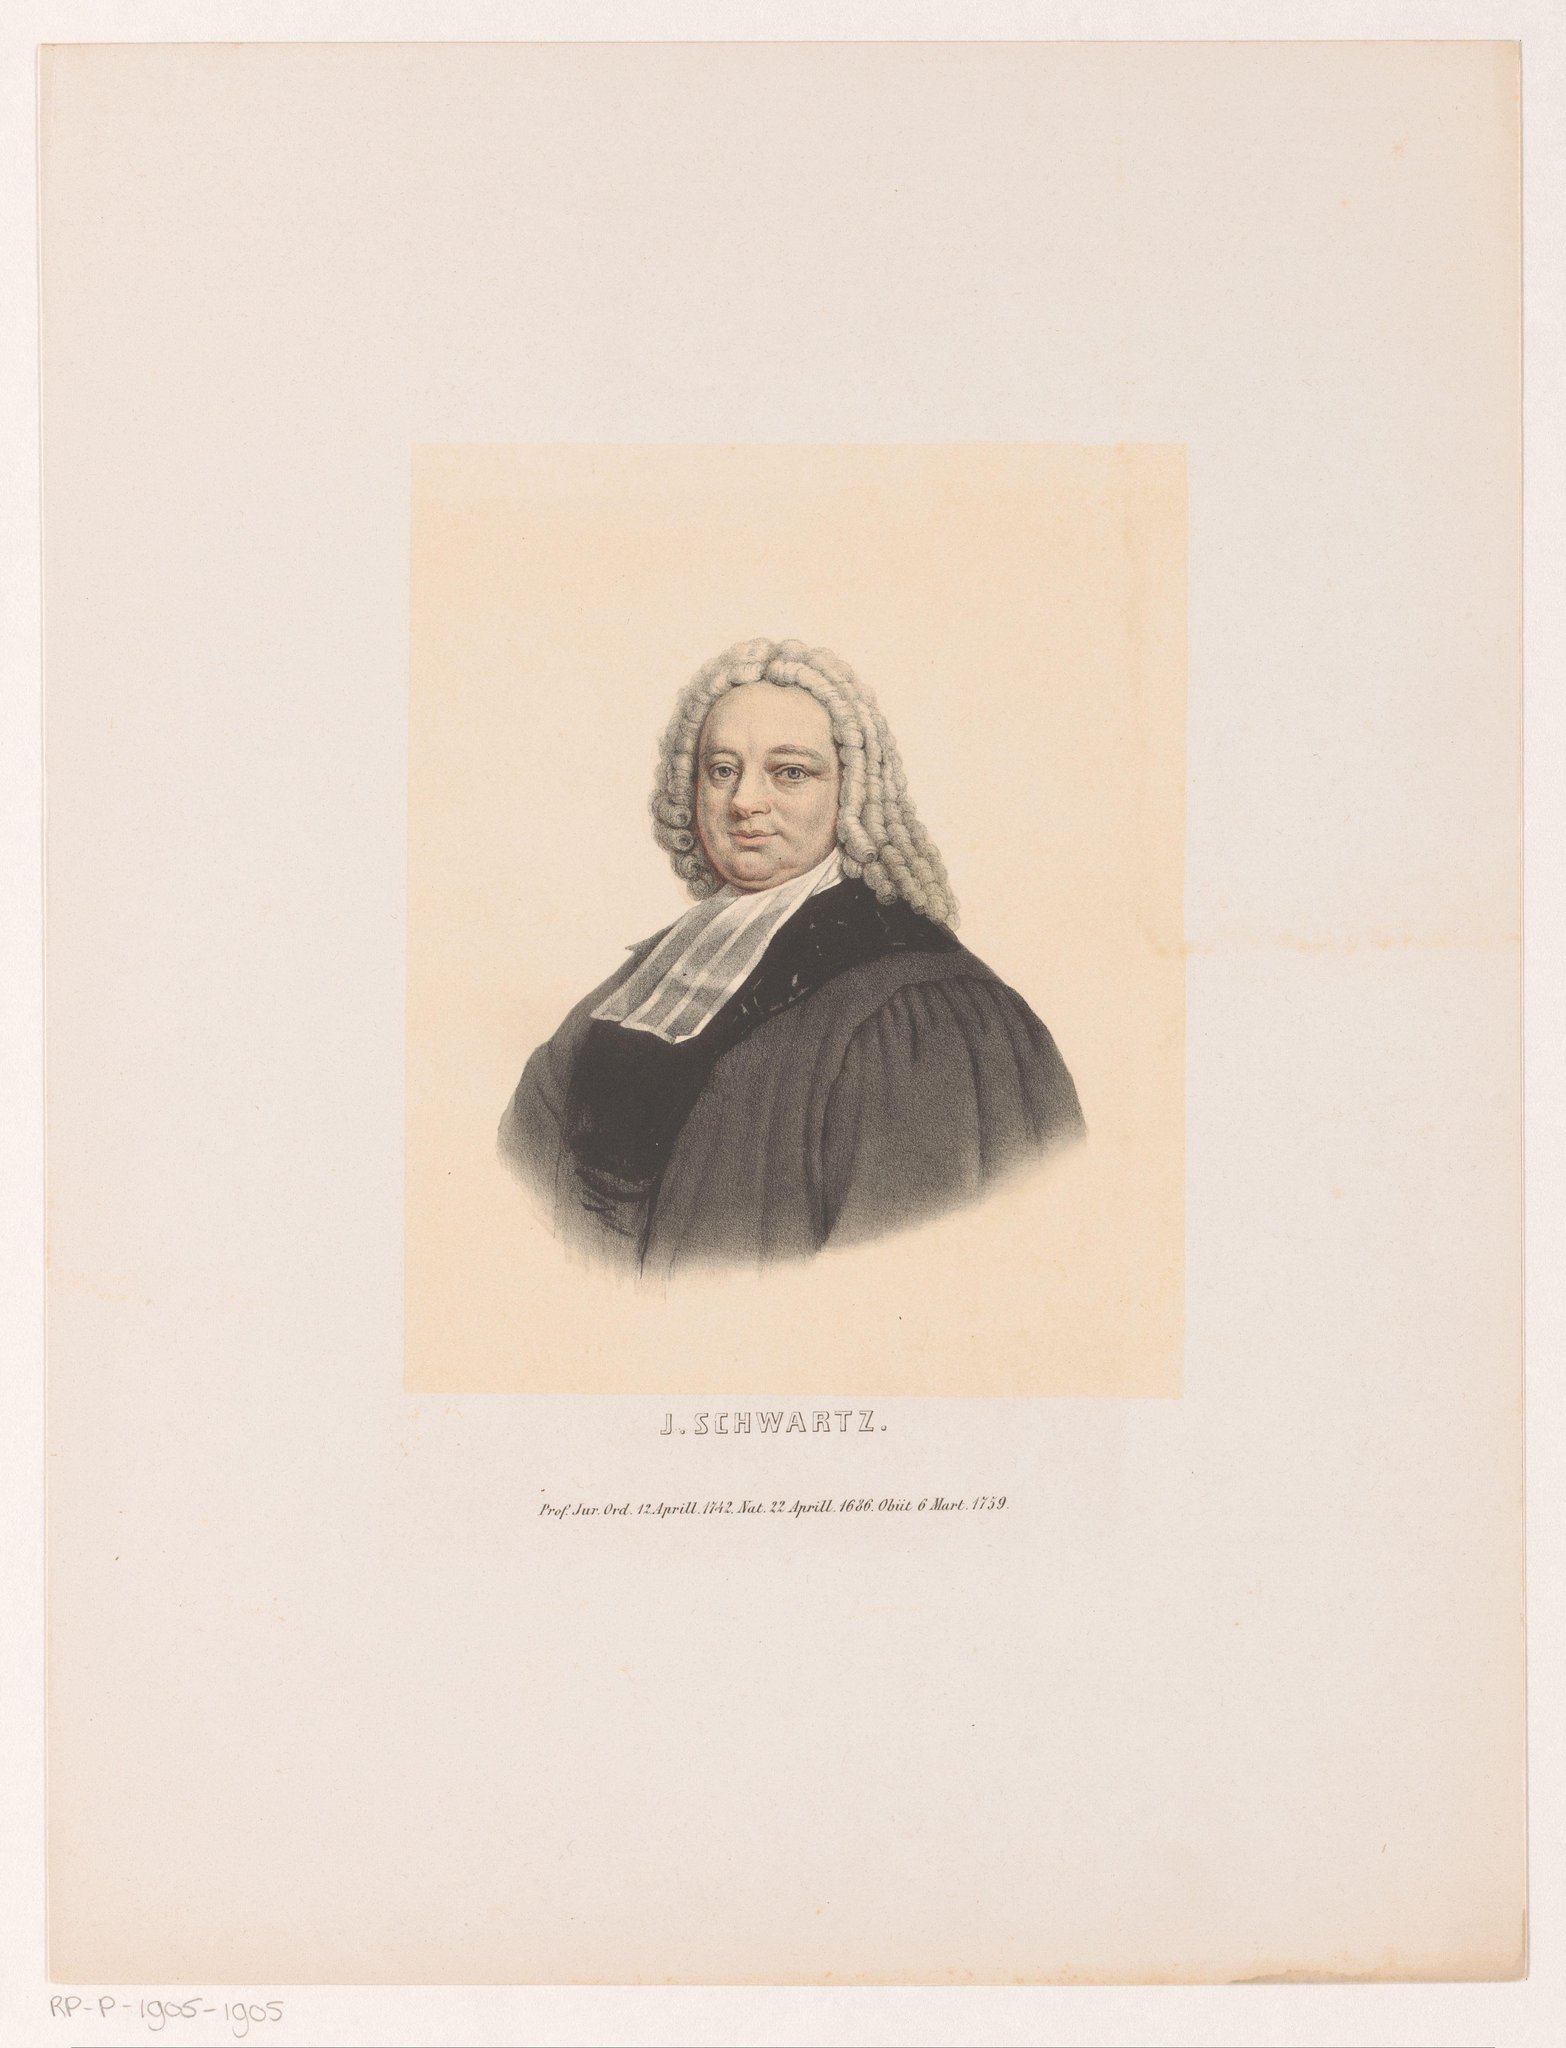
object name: print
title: Portret van Joachimus Schwartz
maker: leendert springer (i)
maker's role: draughtsman, painter, print maker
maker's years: 1789-1871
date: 1850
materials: paper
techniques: lithograph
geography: leiden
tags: historical persons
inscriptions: collector's mark: Lugt 2228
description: Prent uit: Springer, Leendert. Galerij van hoogleeraren aan de Hoogeschool te Leijden, naar de oorspronkelijke afbeeldsels op de Senaat-zaal aldaar berustende. Leiden: Springer, Leendert., s.a. [circa 1850].